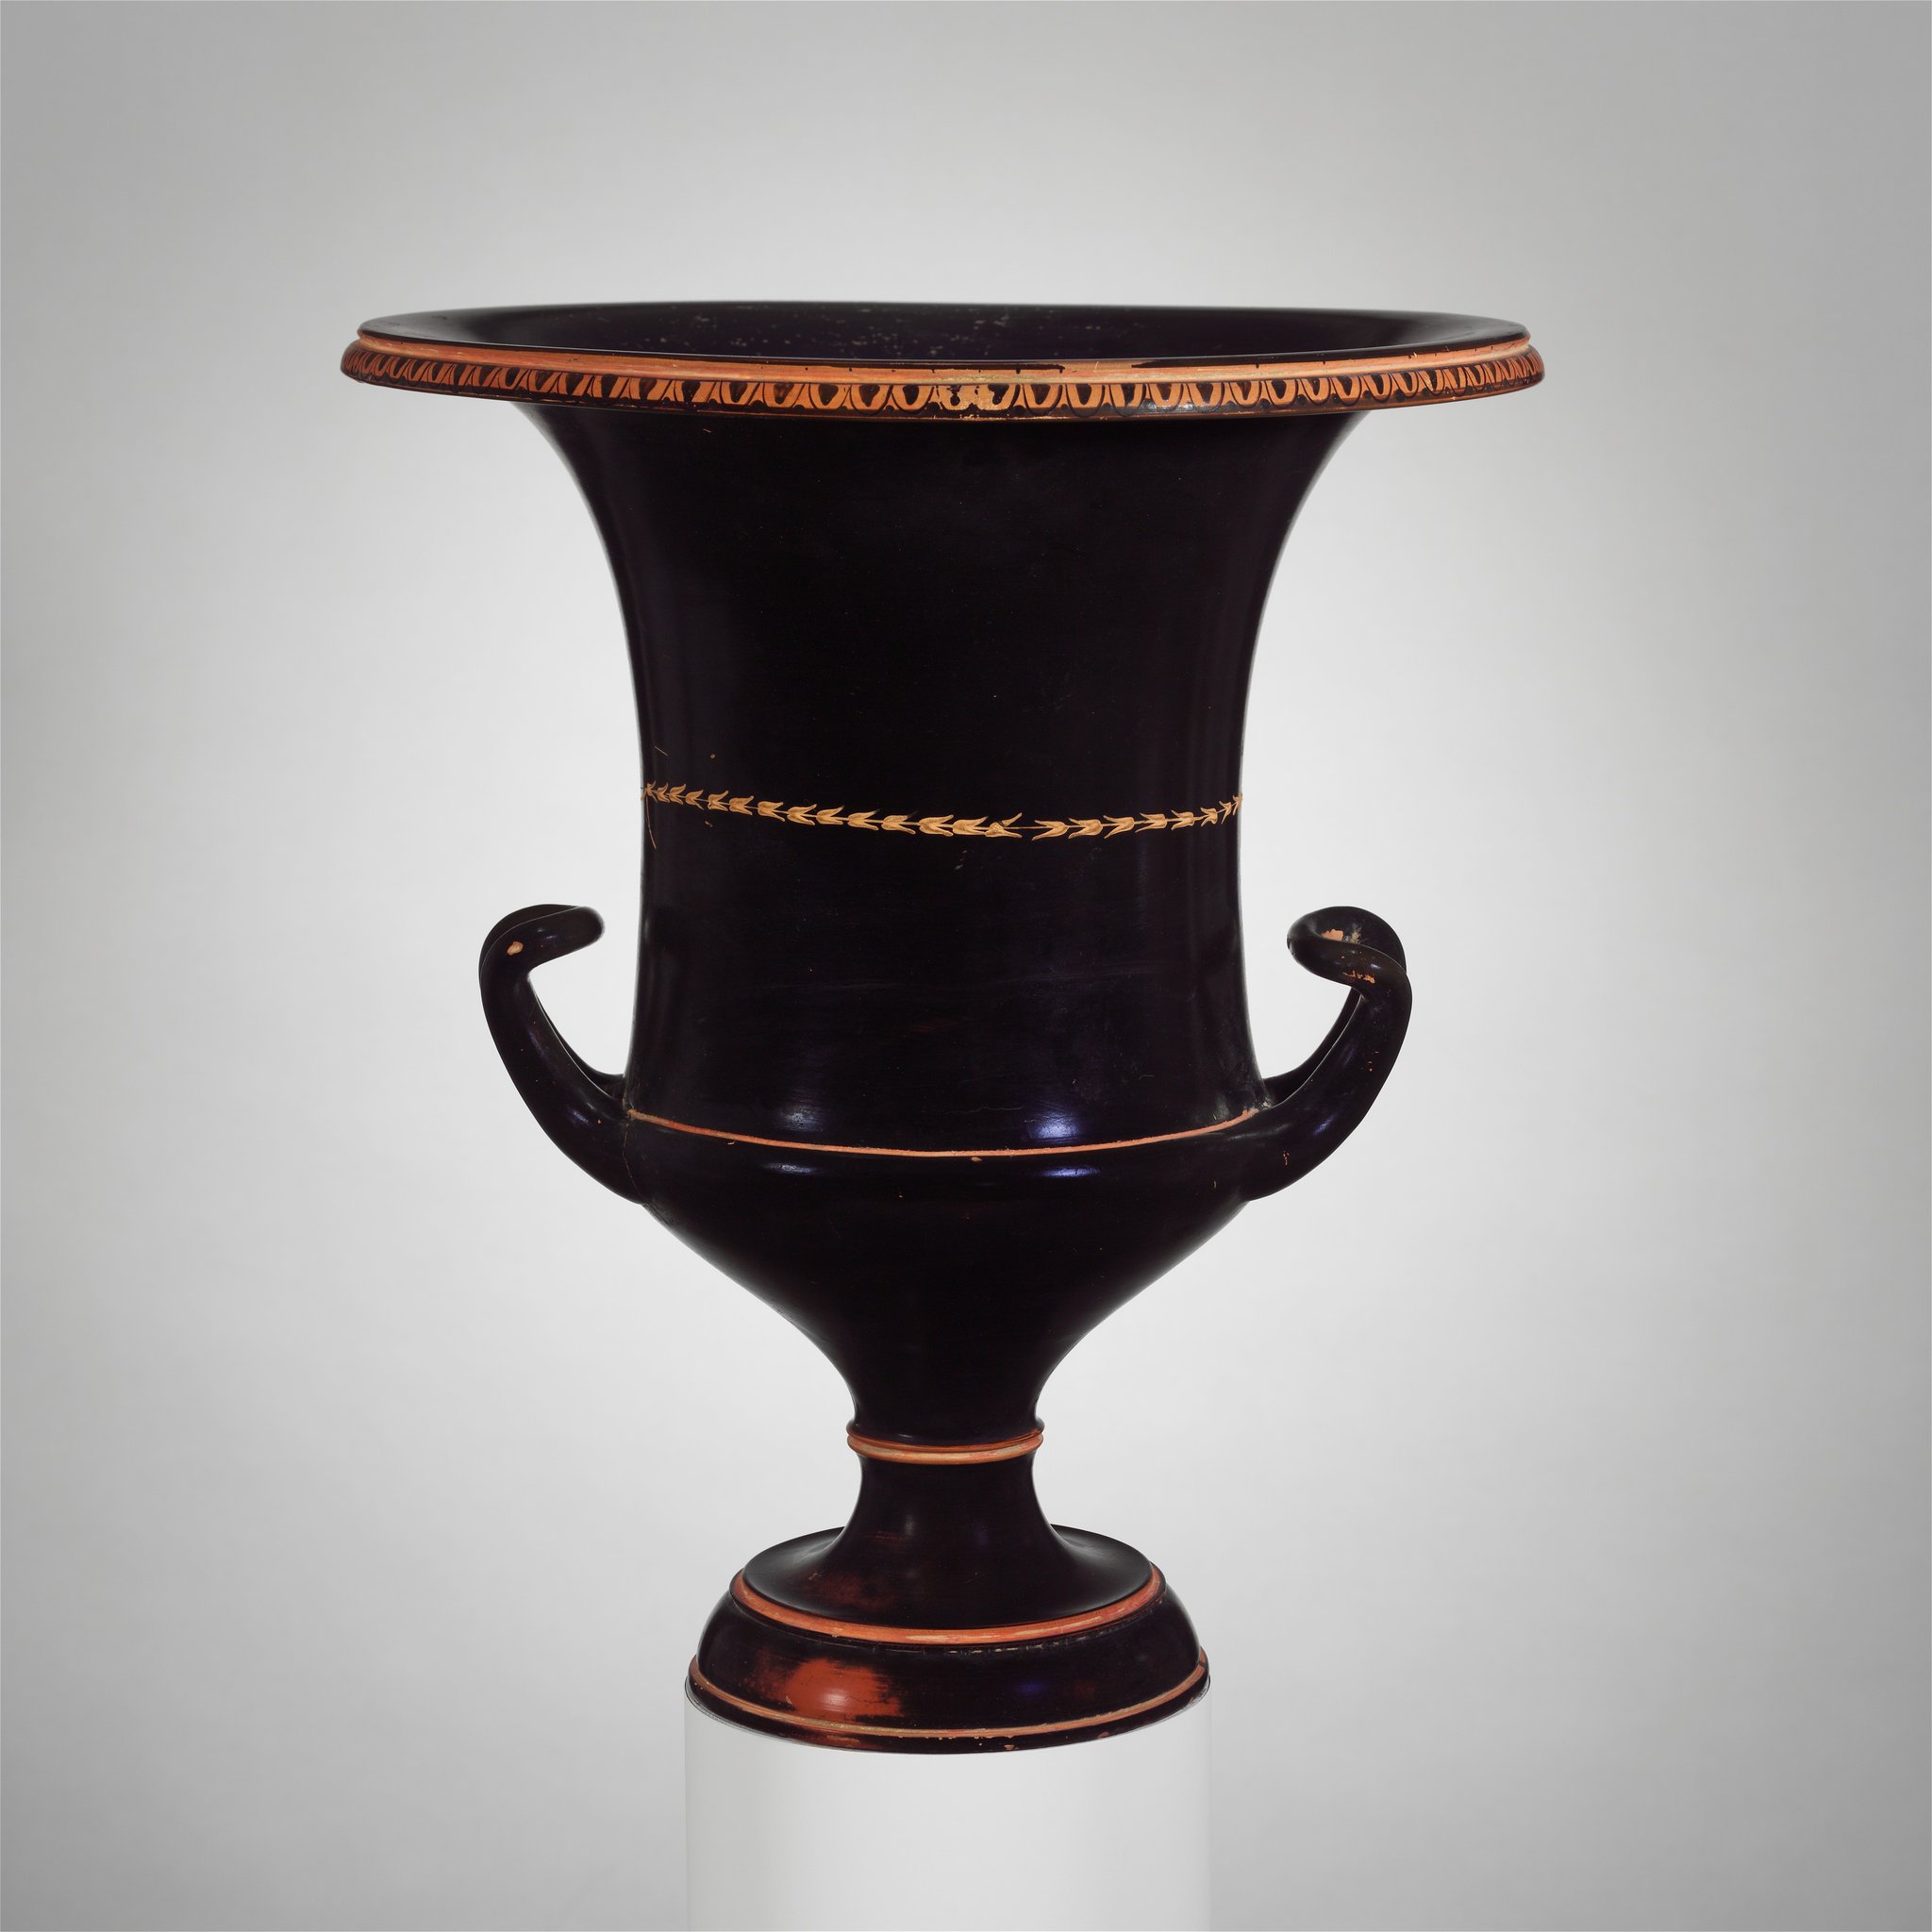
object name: calyx krater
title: Terracotta calyx-krater (bowl for mixing wine and water)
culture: greek, attic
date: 400-301 BCE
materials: terracotta